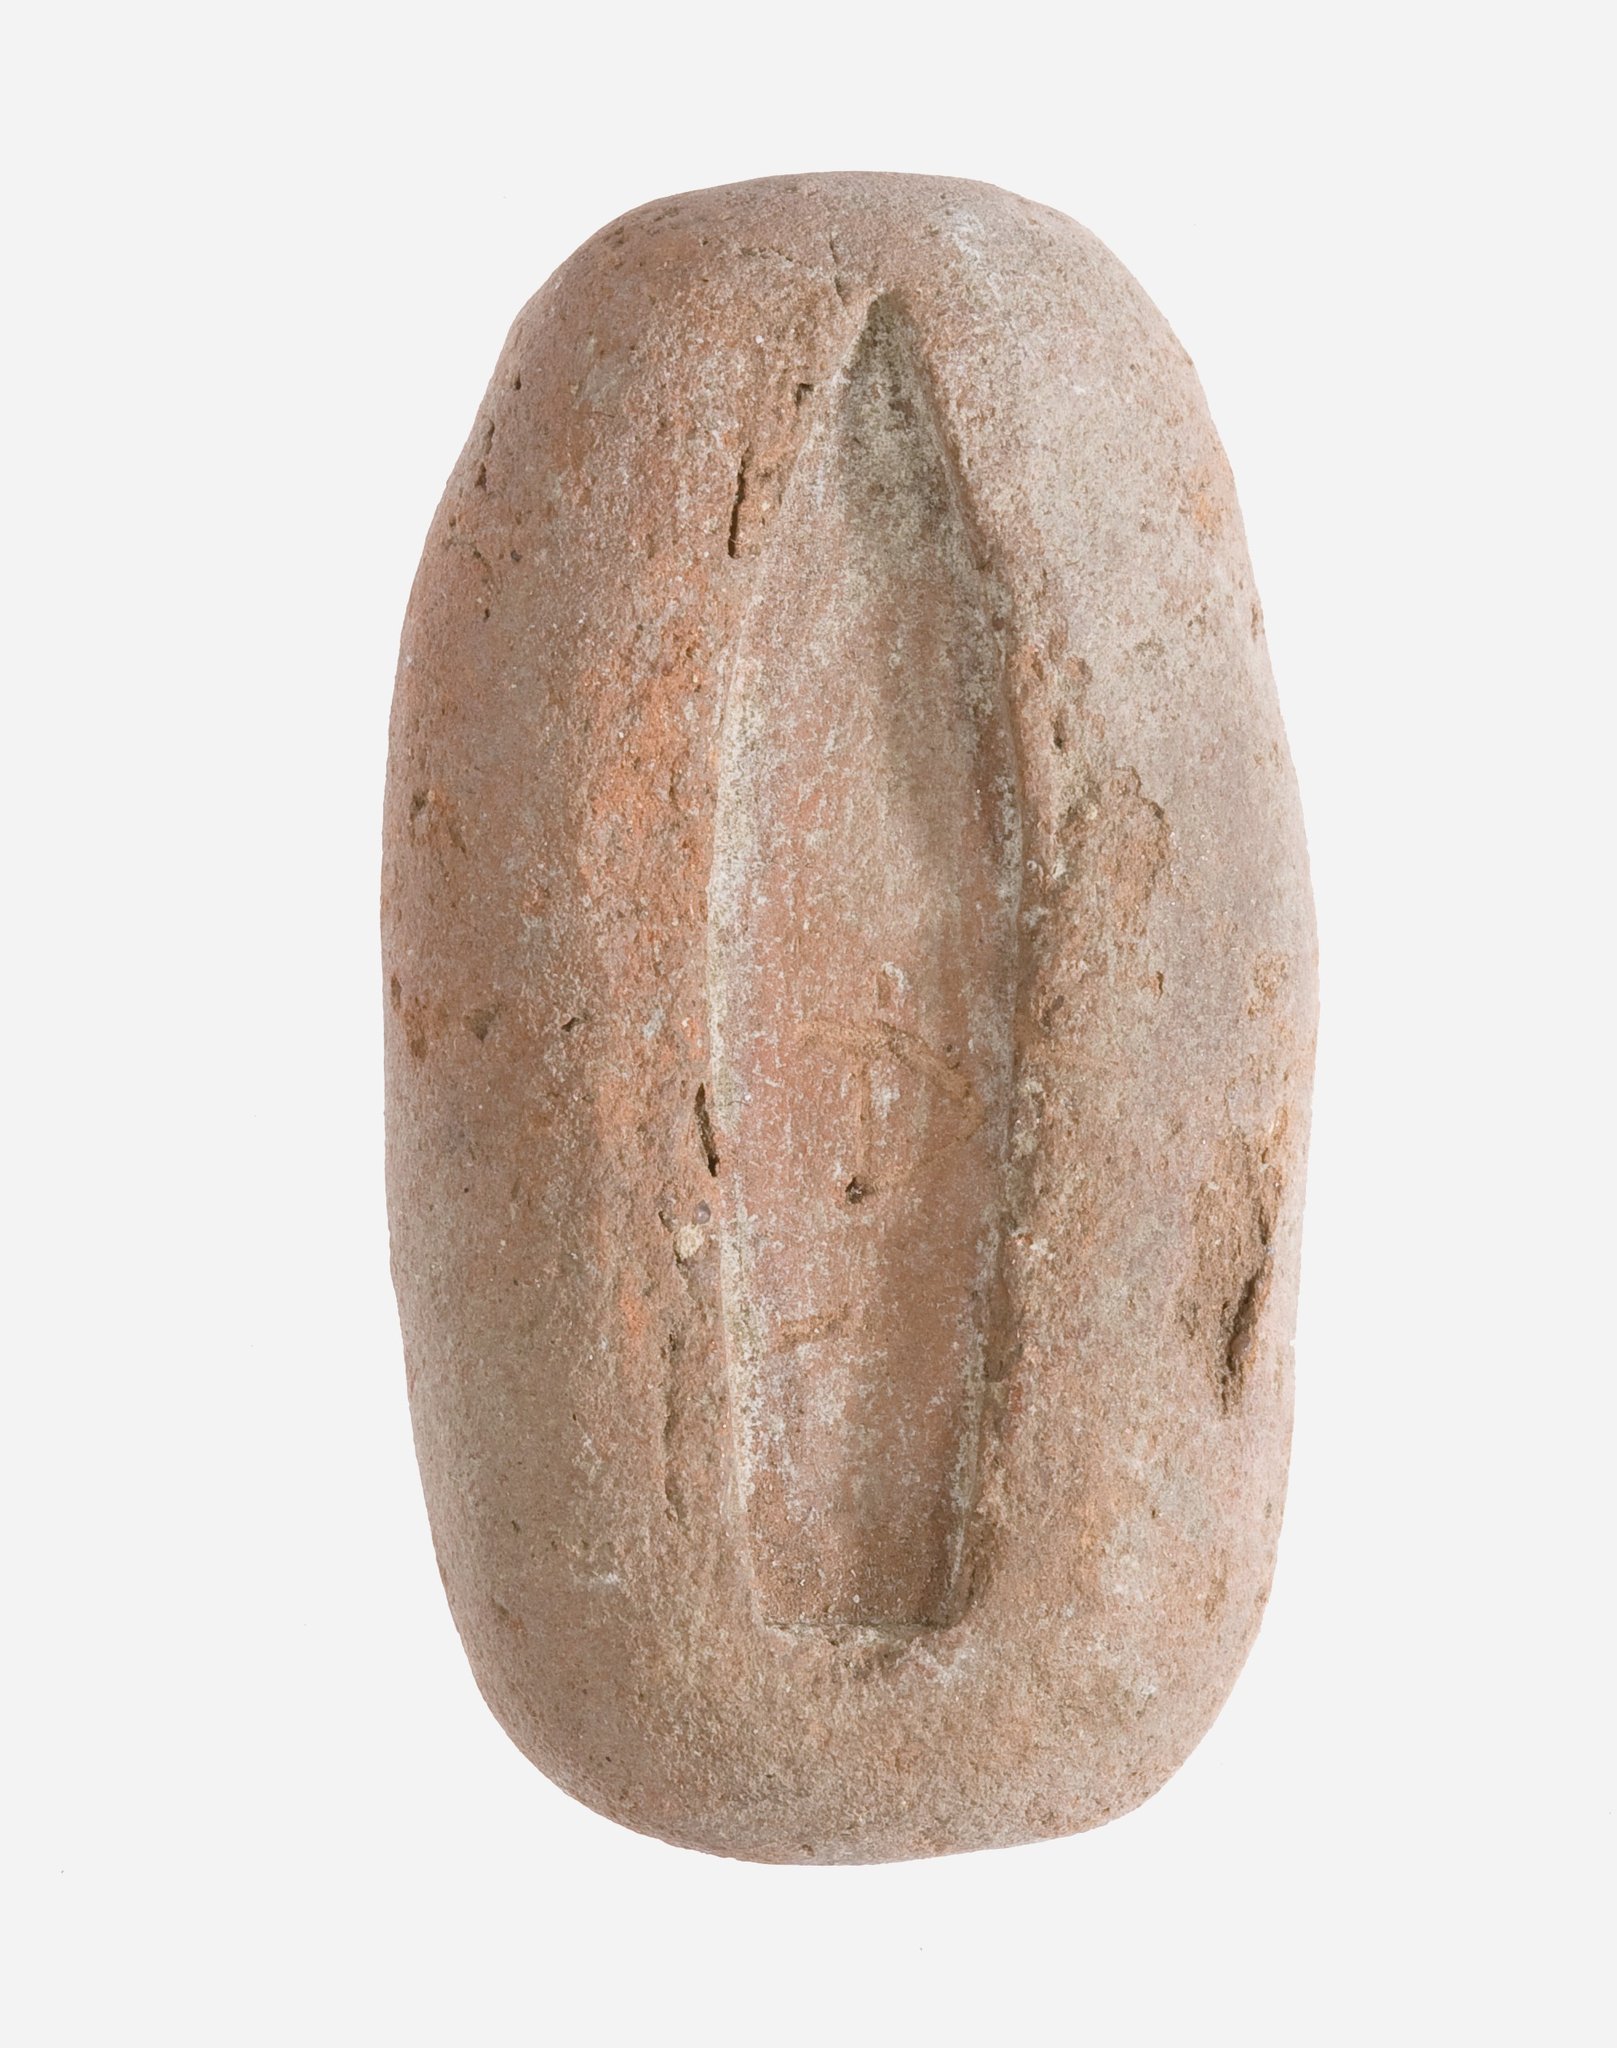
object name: mold, bead, lotus petal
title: Mold of a Lotus Petal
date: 1390-1352 BCE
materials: pottery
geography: egypt